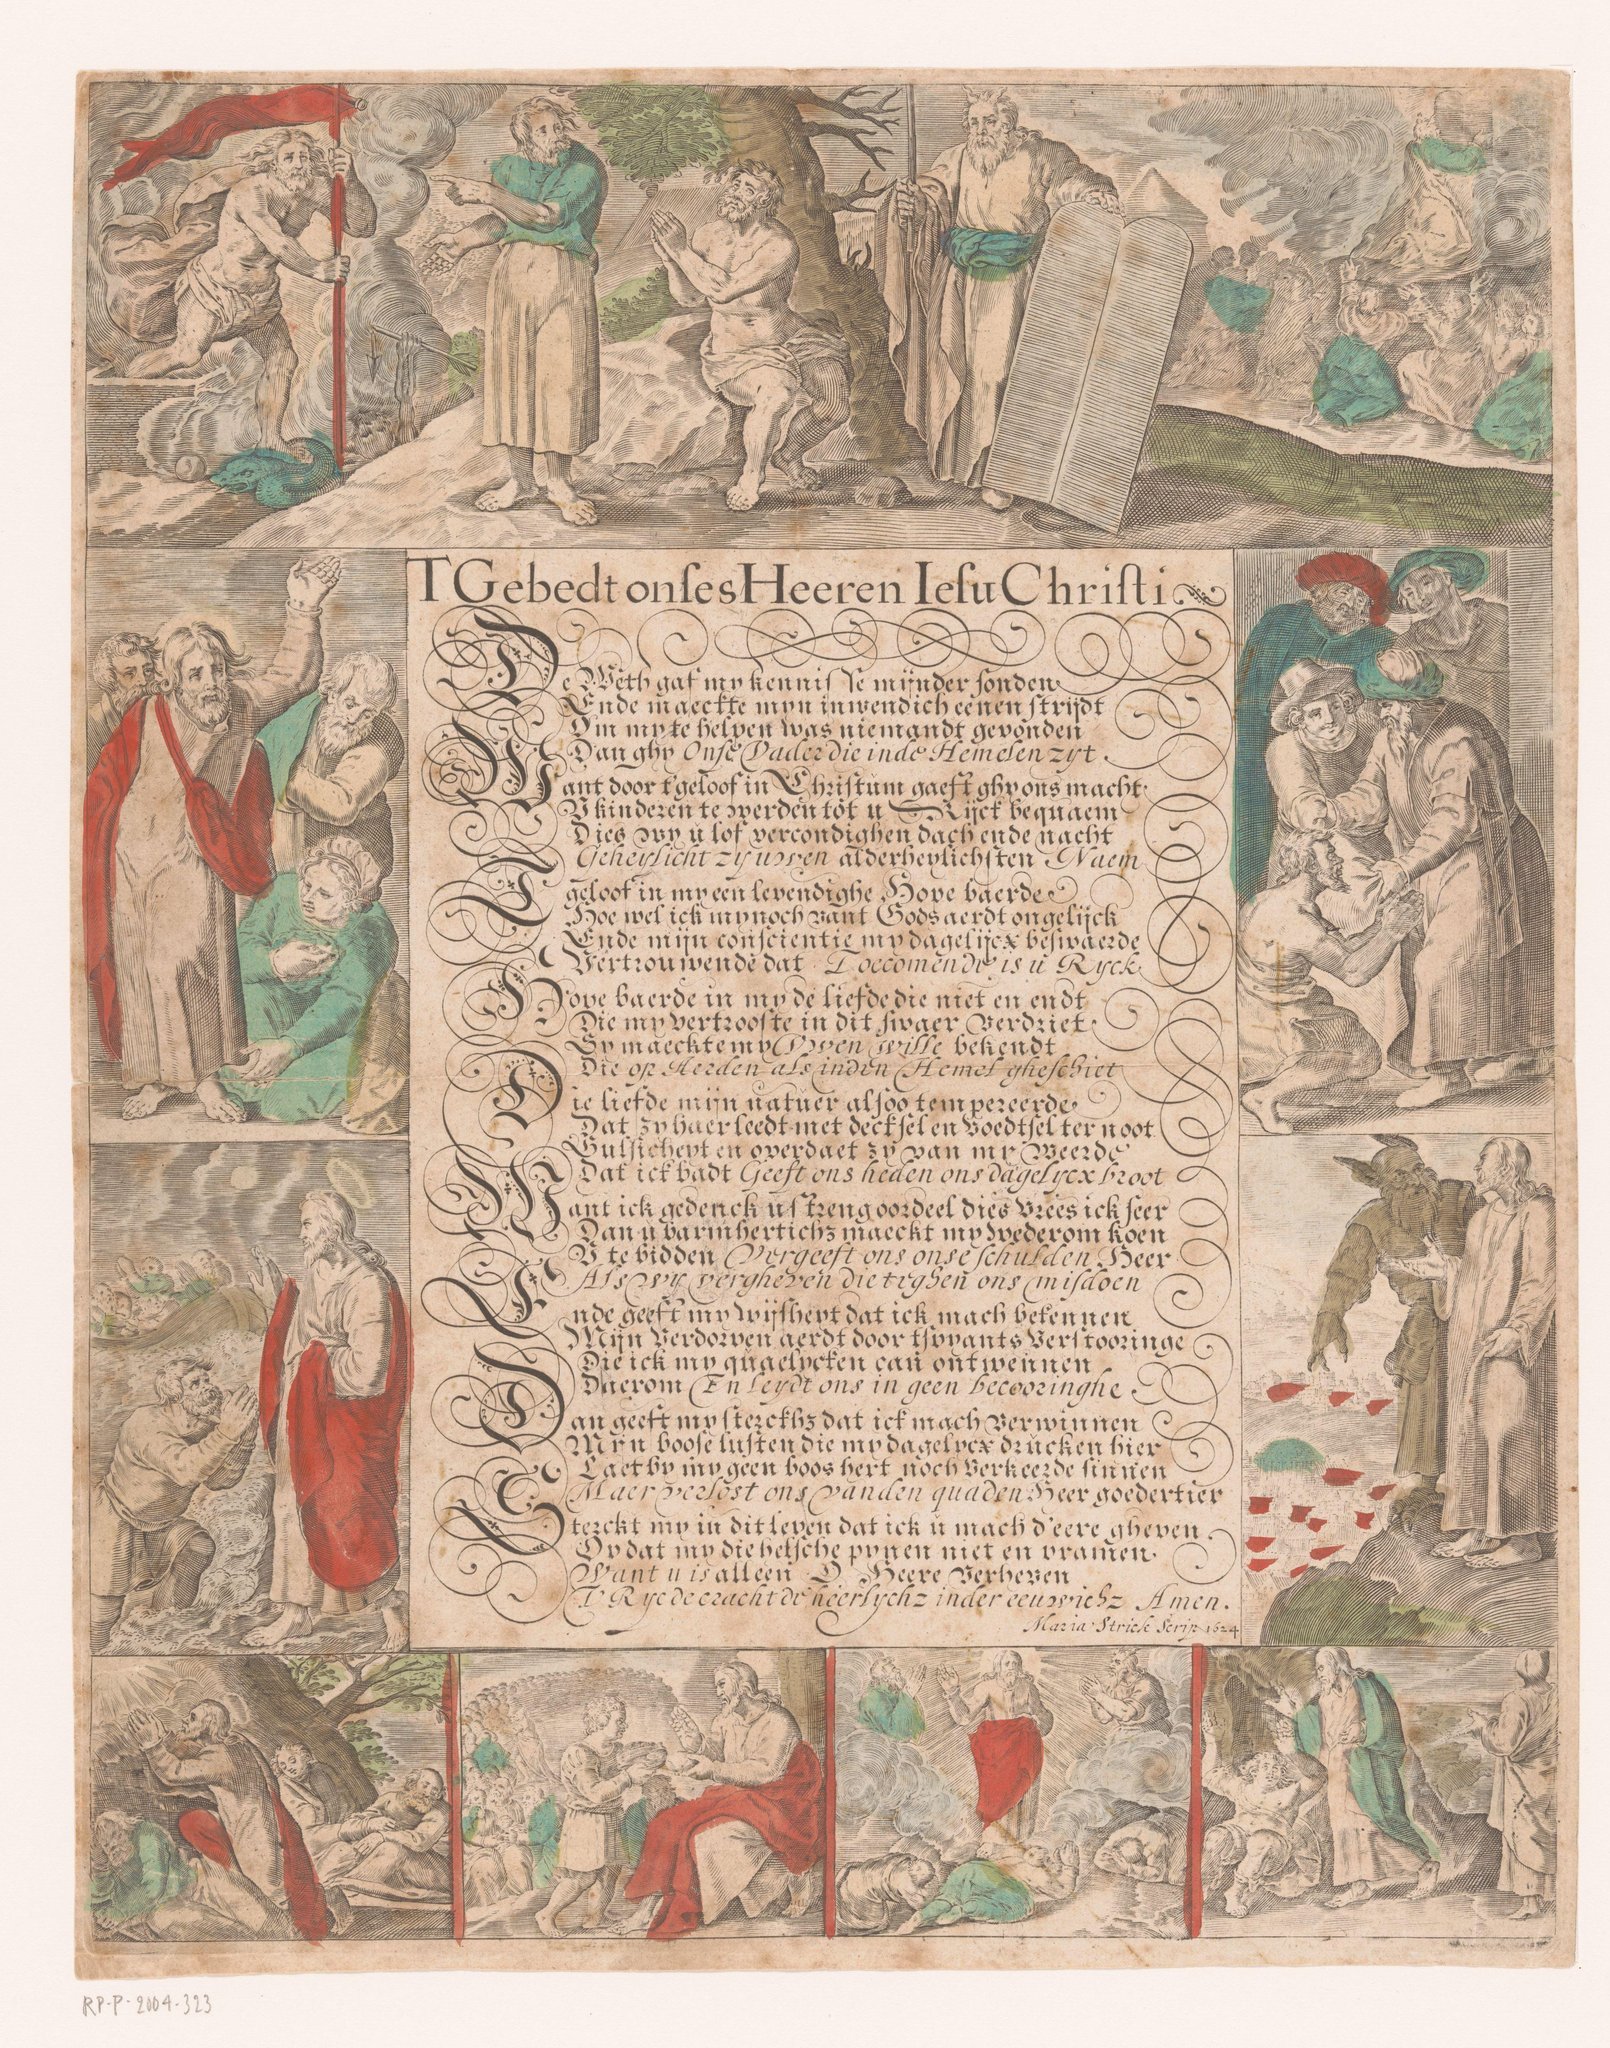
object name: ornament print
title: T Gebedt Onses Heeren Iesu Christi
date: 1624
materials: paper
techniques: engraving, hand coloring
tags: new testament, calligraphy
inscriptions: collector's mark: Lugt 2228, collector's mark: Lugt 2760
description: Een gekalligrafeerd gebed. Rondom de tekst scènes uit het leven van Christus.